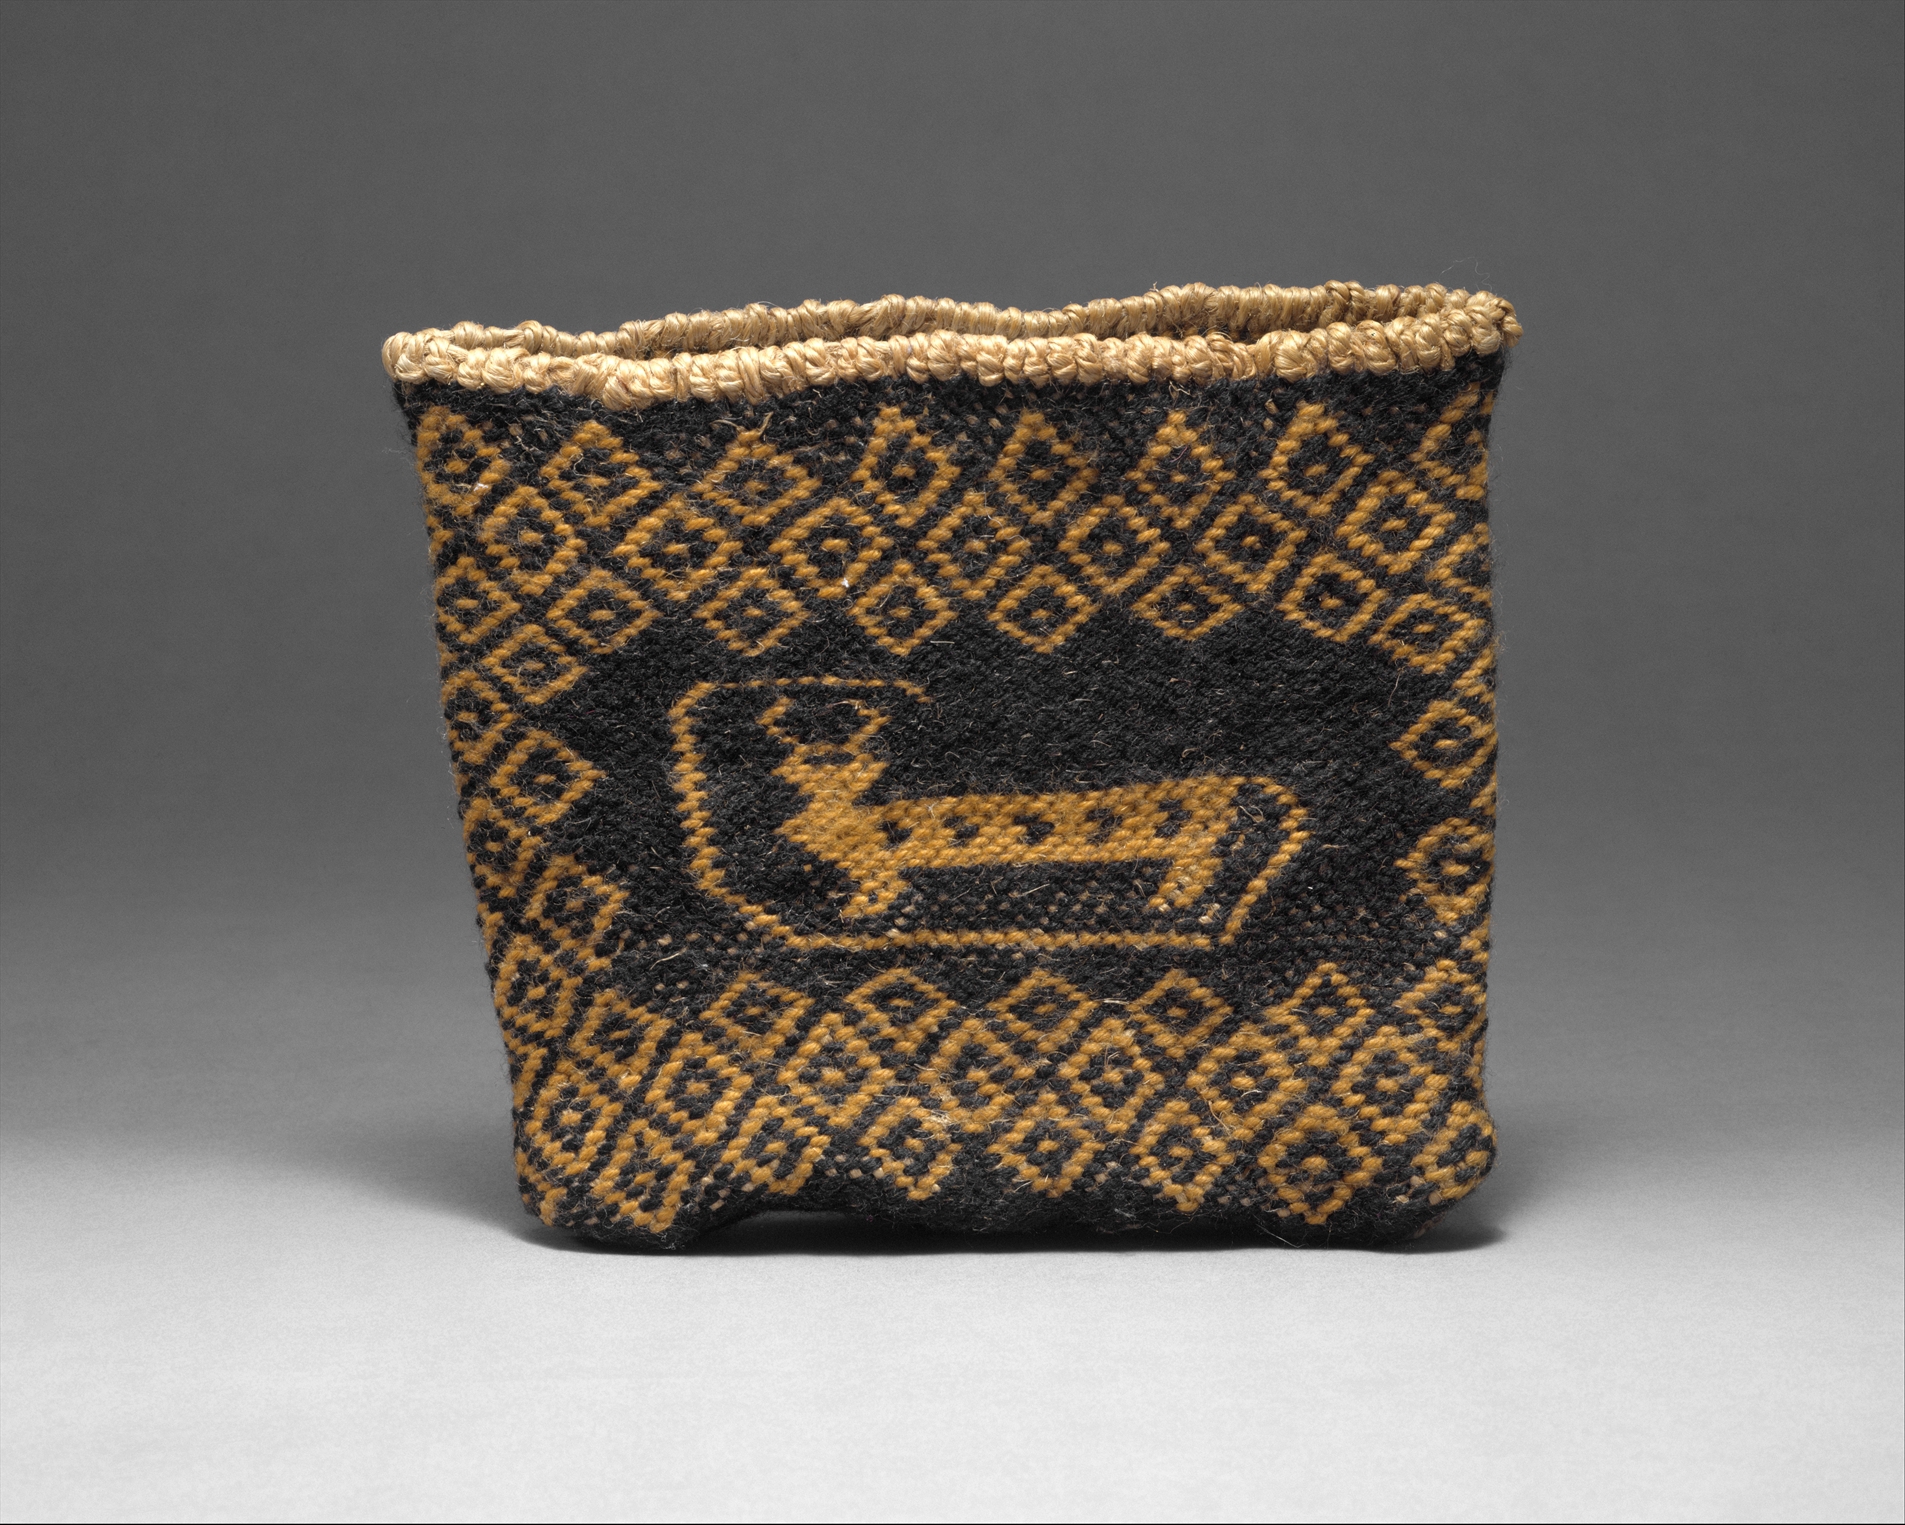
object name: charm bag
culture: ojibwa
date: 1875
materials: fiber, wool, thread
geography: united states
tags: animals